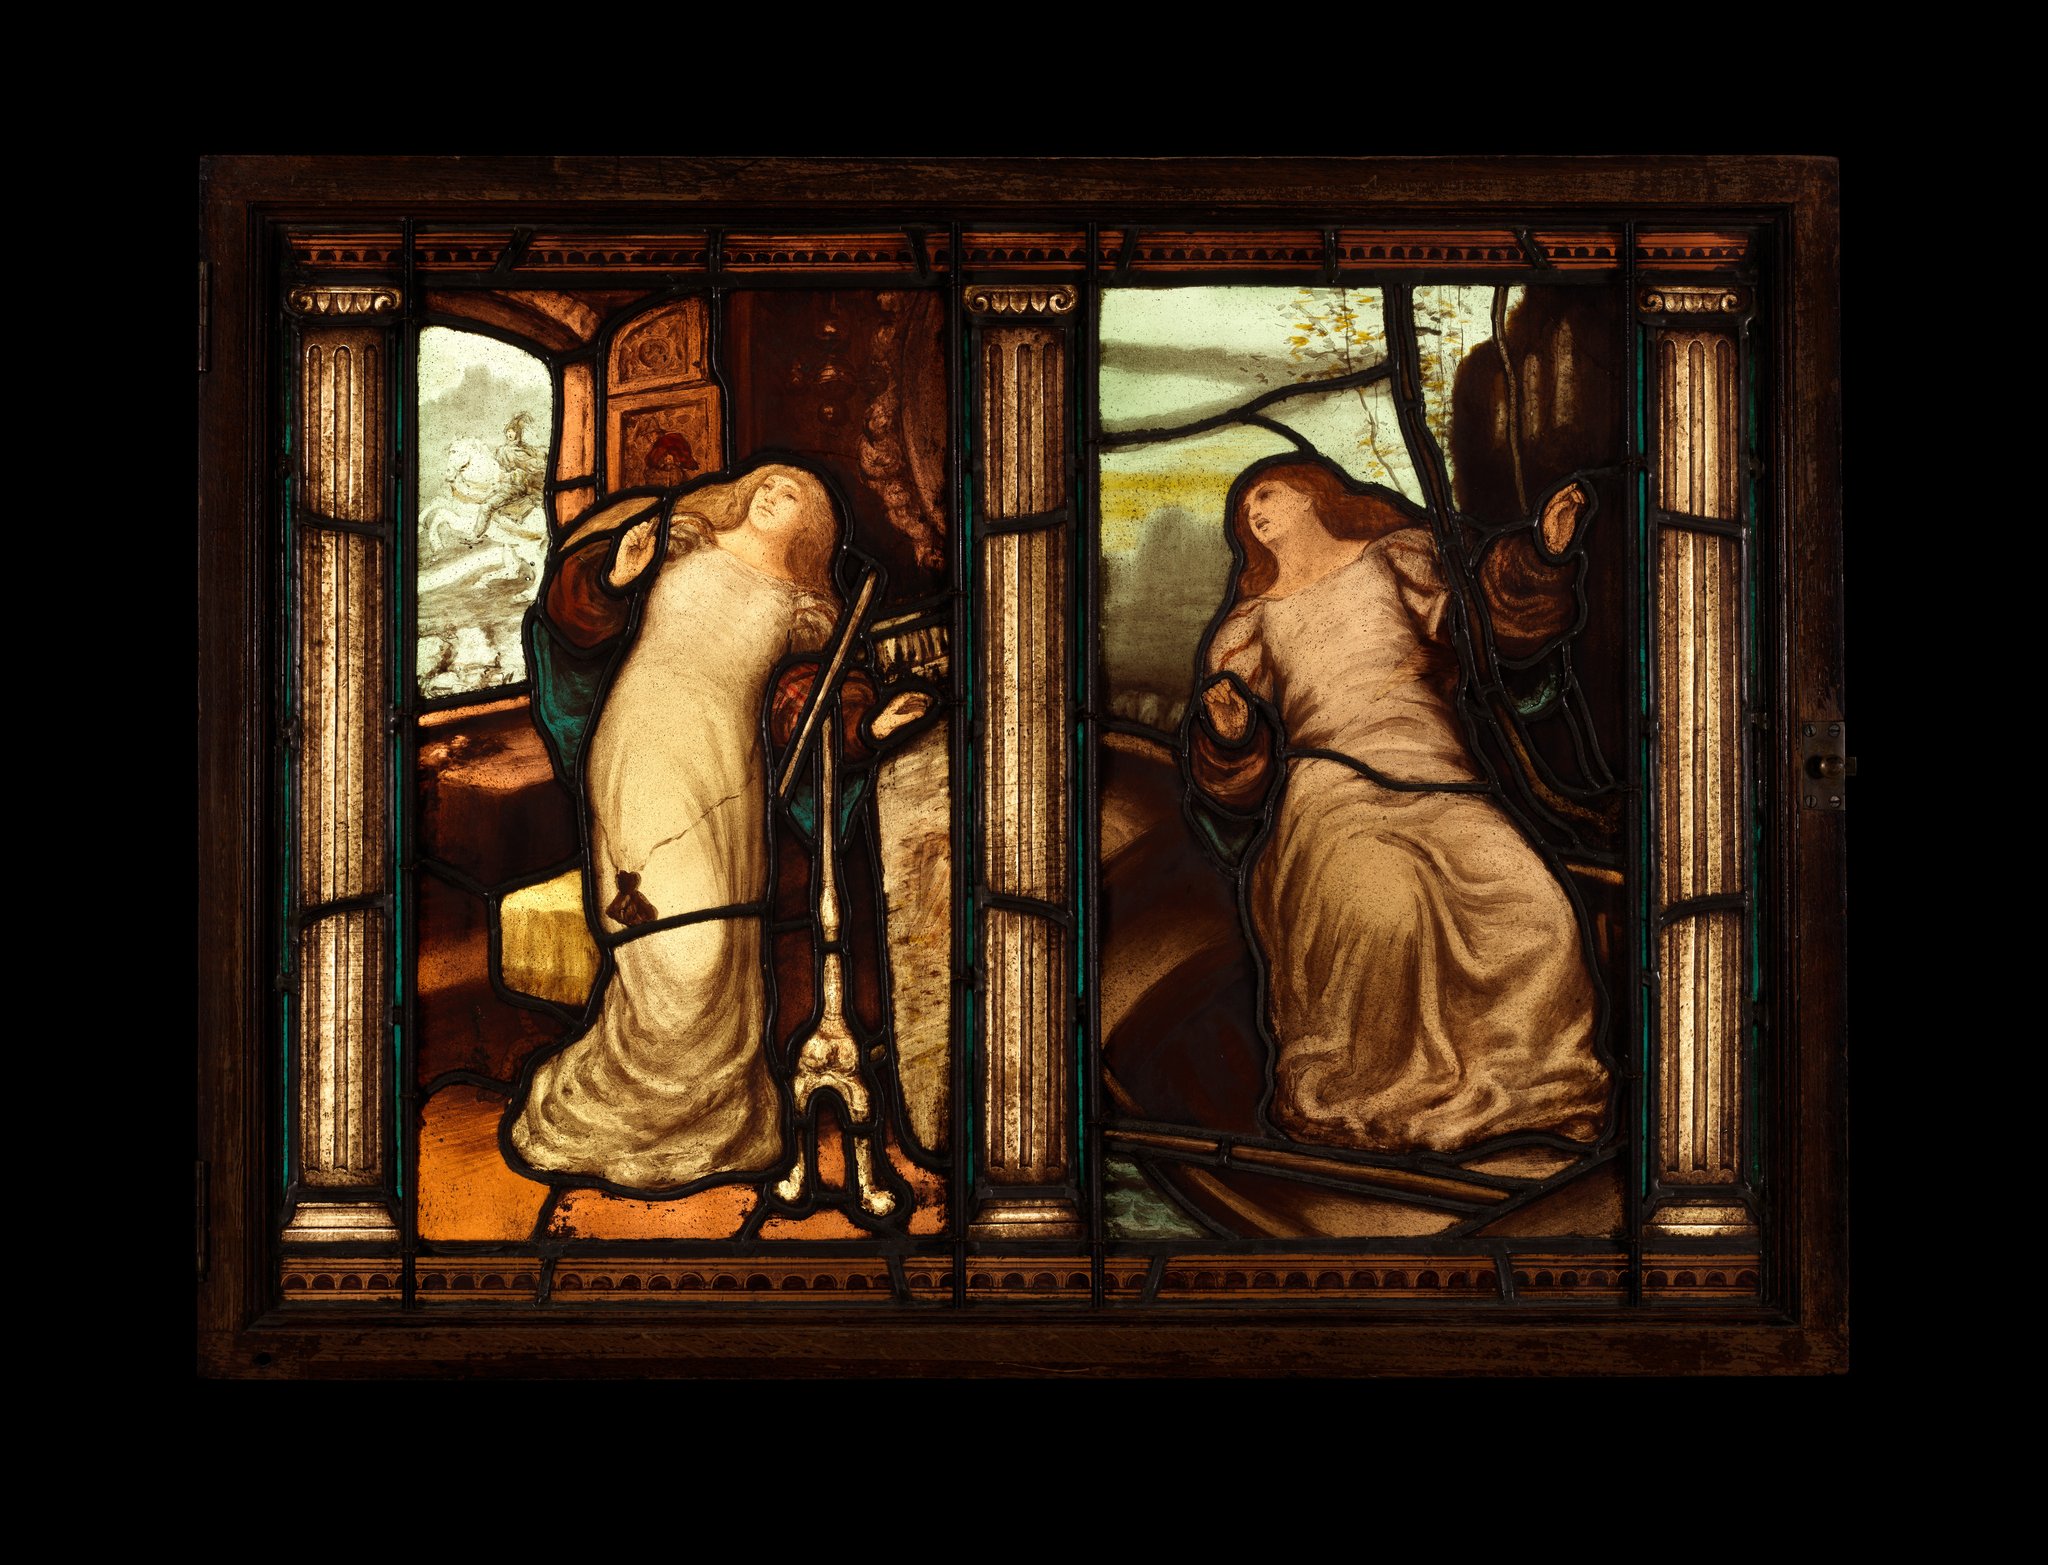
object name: stained glass window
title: The Lady of Shalott stained glass window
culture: american or english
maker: matthys maris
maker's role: designer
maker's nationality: dutch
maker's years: 1839-1917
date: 1890-1915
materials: glass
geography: united states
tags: women